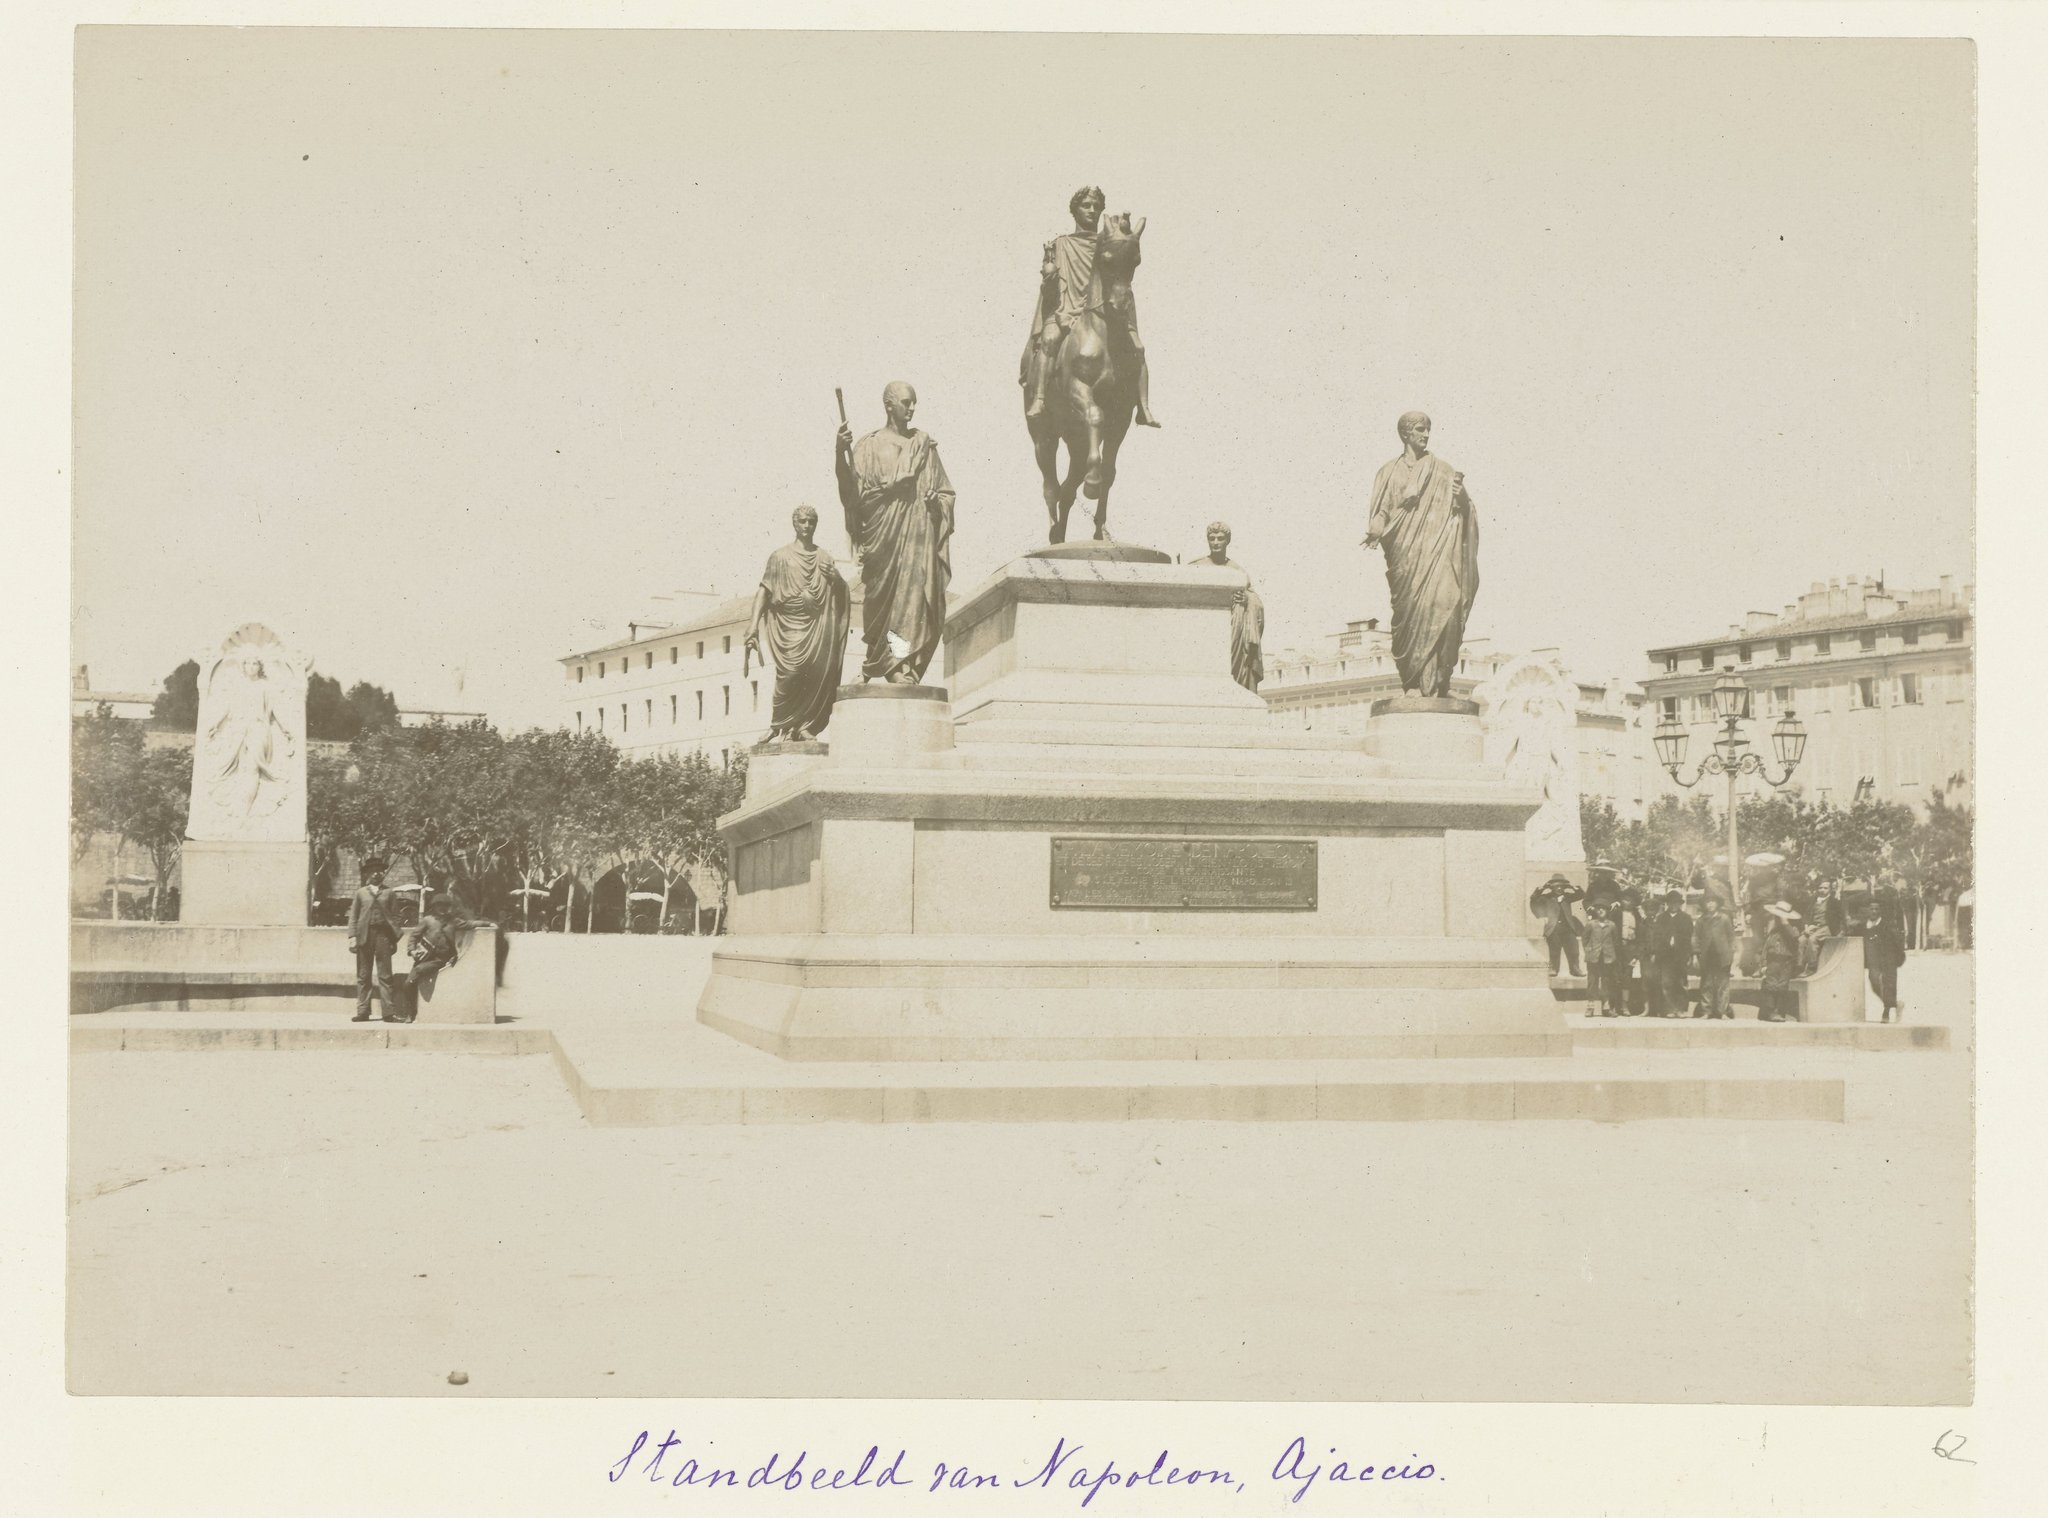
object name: photograph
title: Standbeeld van Napoleon, Ajaccio.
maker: henry pauw van wieldrecht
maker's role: fotograaf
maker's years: 1863-1912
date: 1886-1896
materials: cardboard, photographic support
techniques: albumen print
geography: corsica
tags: ajaccio